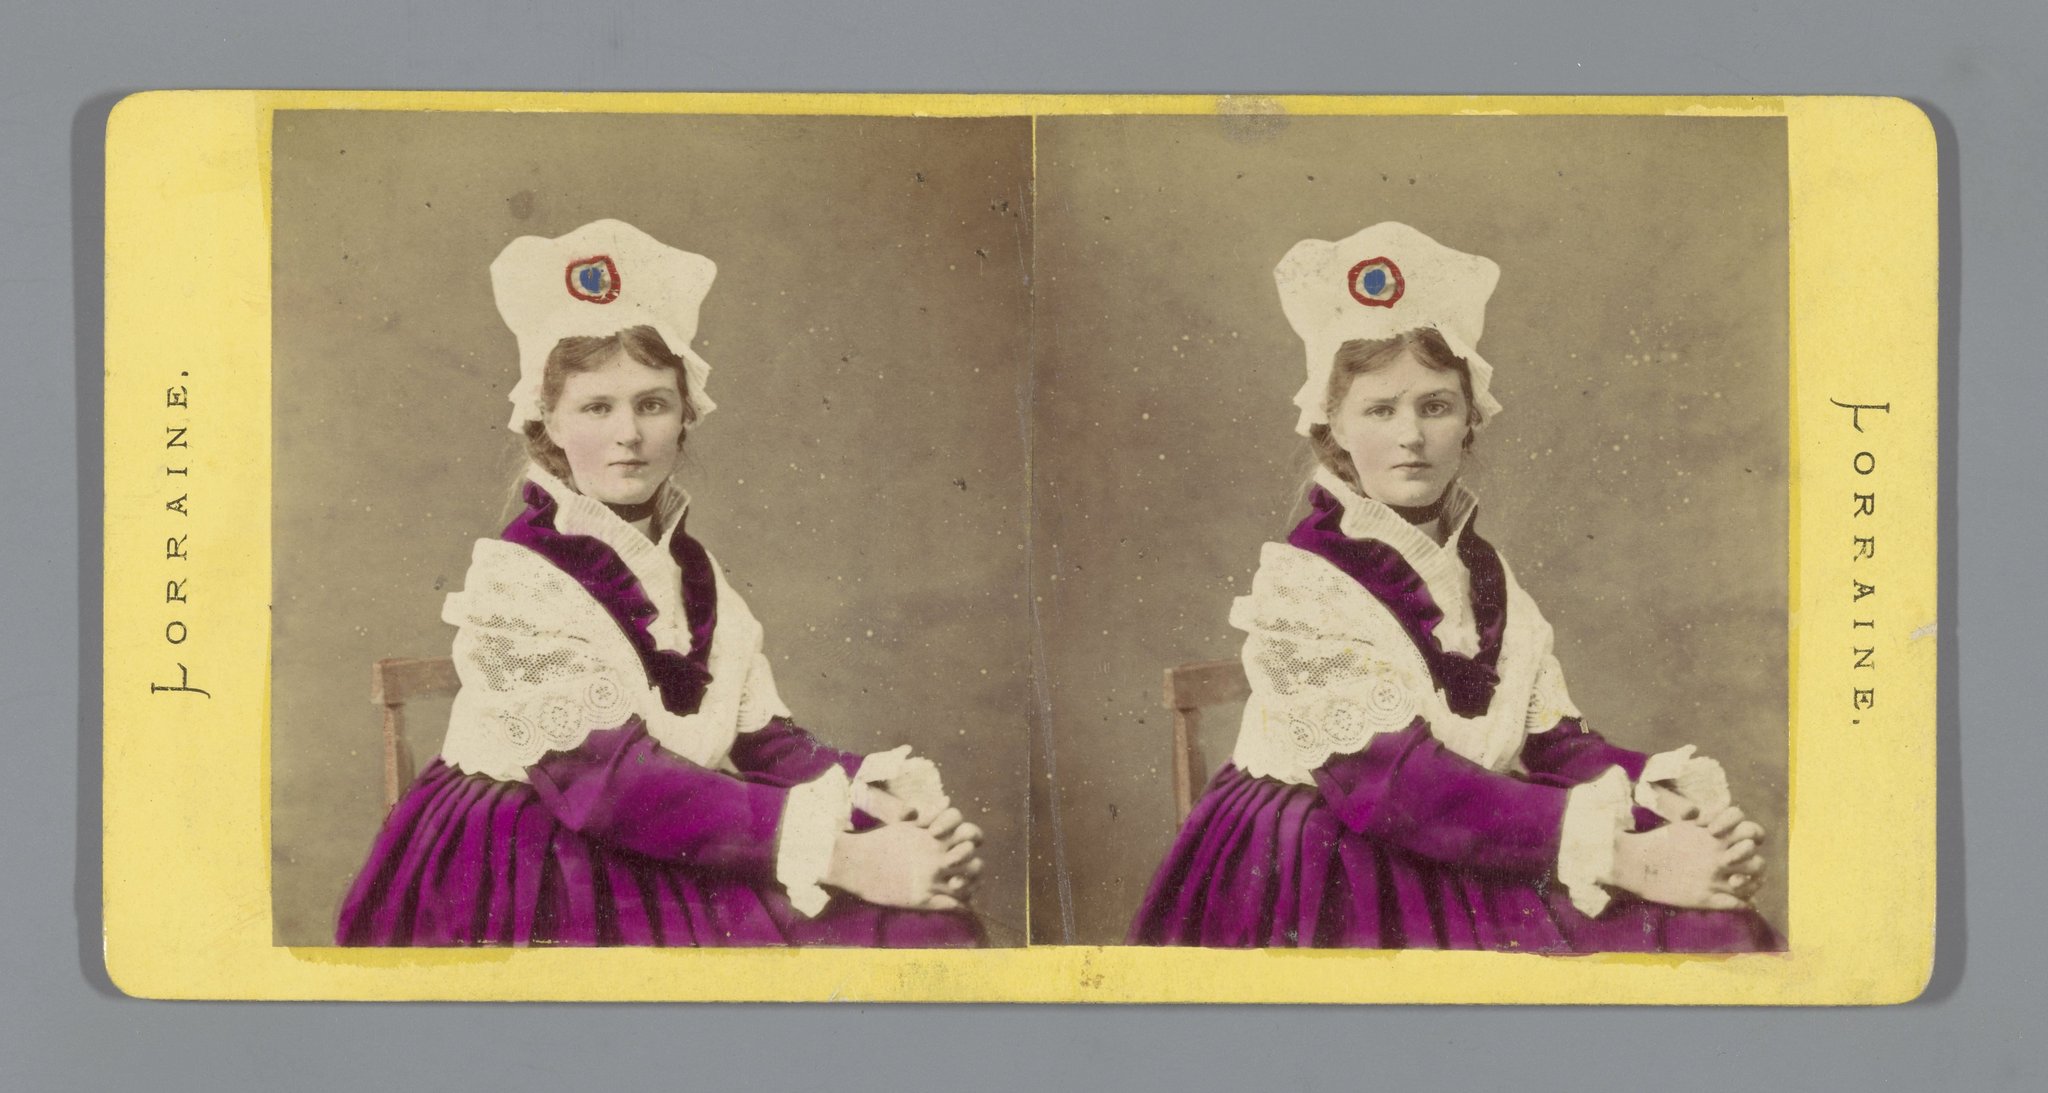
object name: stereograph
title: Portret van een vrouw in Lotharinger klederdracht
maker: Anonymous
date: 1873-1890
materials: cardboard, paper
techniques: albumen print, hand coloring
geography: france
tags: adult woman, anonymous historical person portrayed, folk costume, regional costume